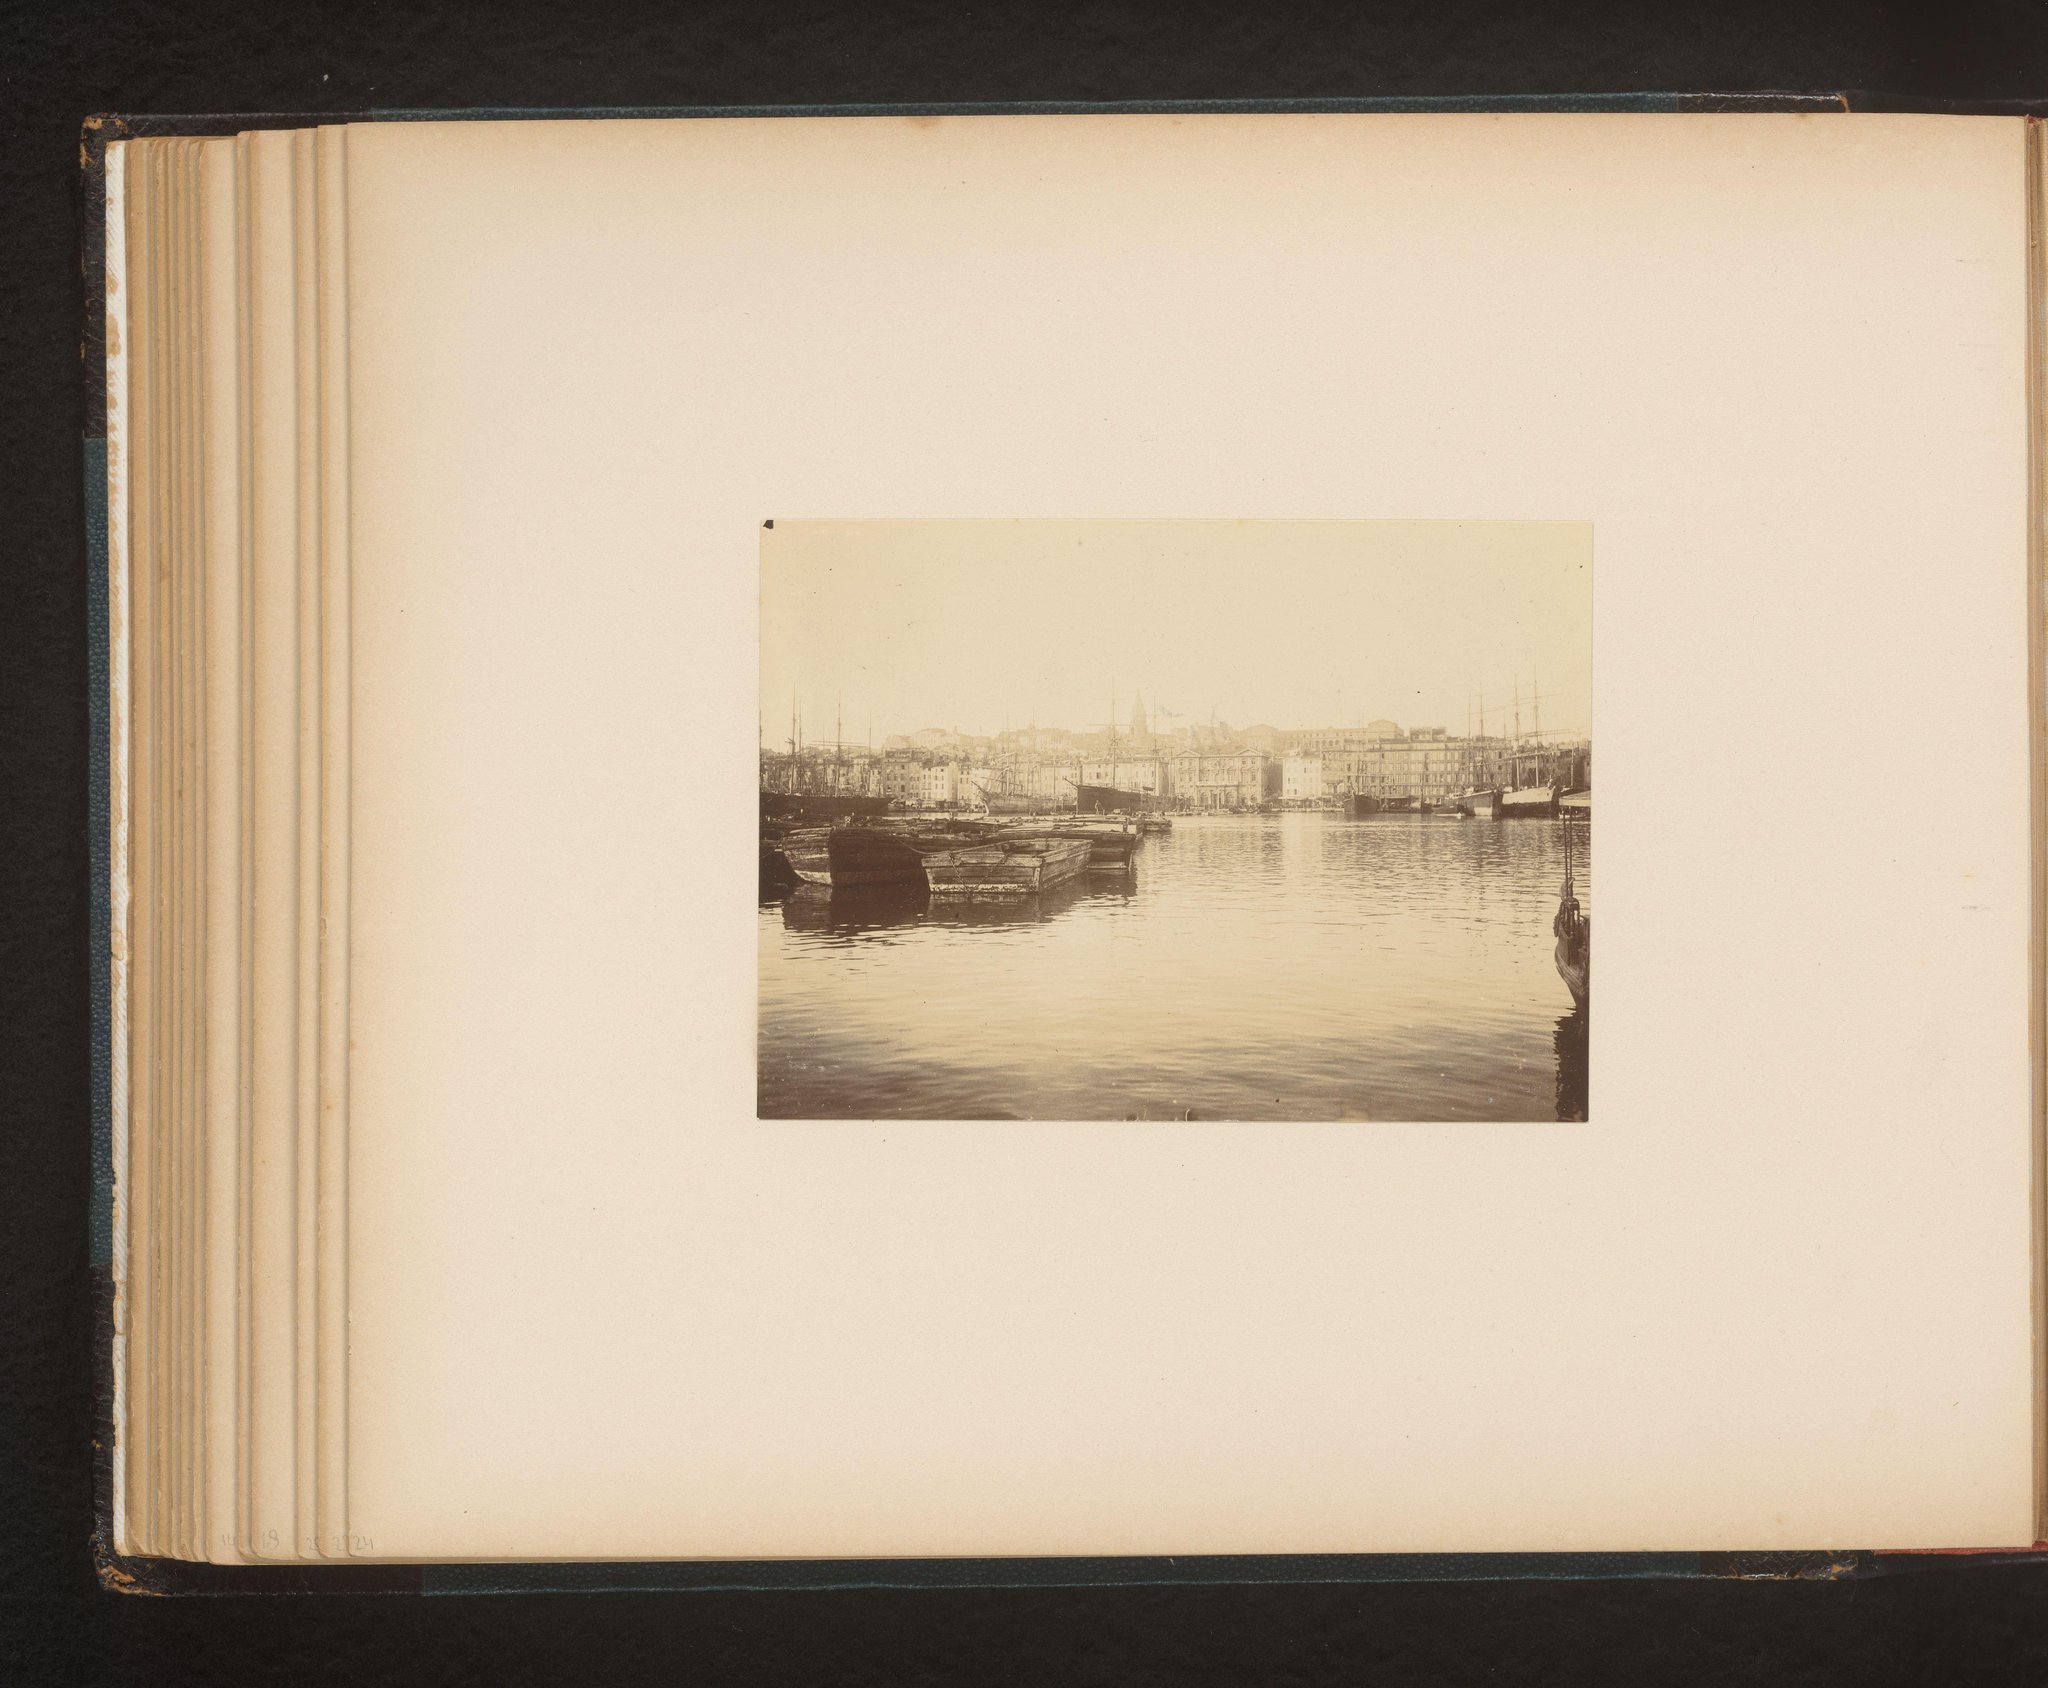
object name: photograph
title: Gezicht op schepen en een stad vanaf het water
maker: Anonymous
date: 1880-1920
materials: cardboard, photographic support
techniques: gelatin silver print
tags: ships (in general), civic architecture; edifices; dwellings, france